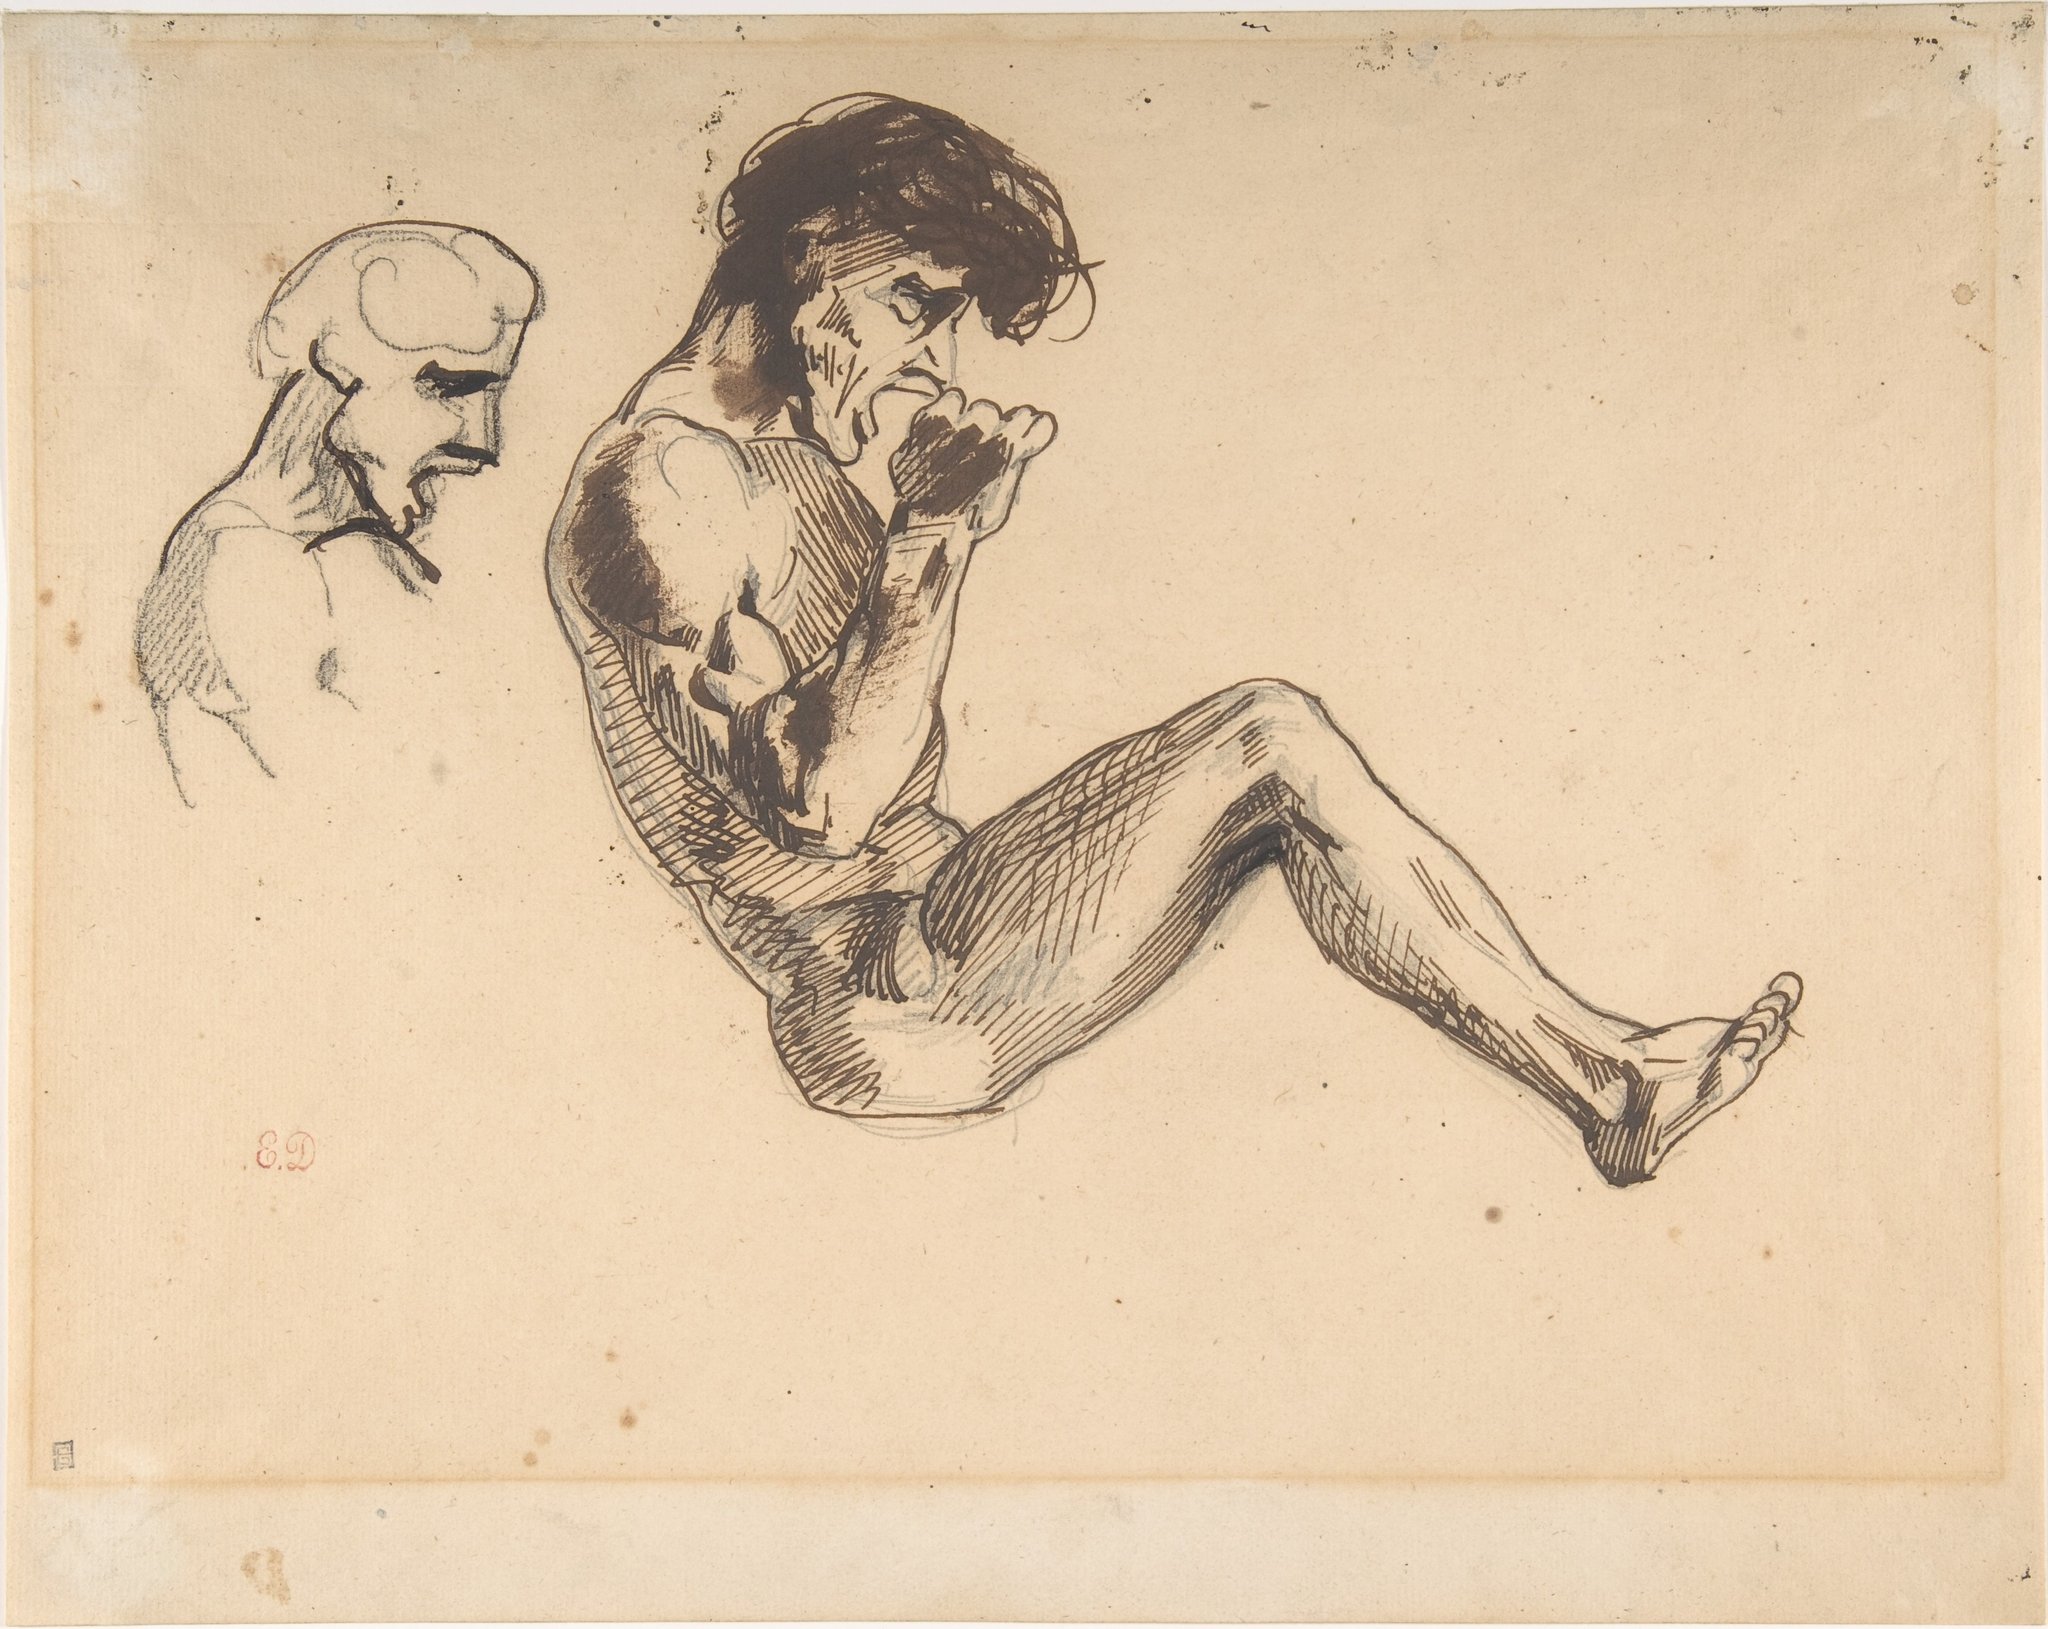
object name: drawing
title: Studies of a Damned Man, for "The Barque of Dante"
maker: eugène delacroix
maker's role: artist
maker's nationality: french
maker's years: 1798-1863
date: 1822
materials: chalk, graphite, ink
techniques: pen, wash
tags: male nudes